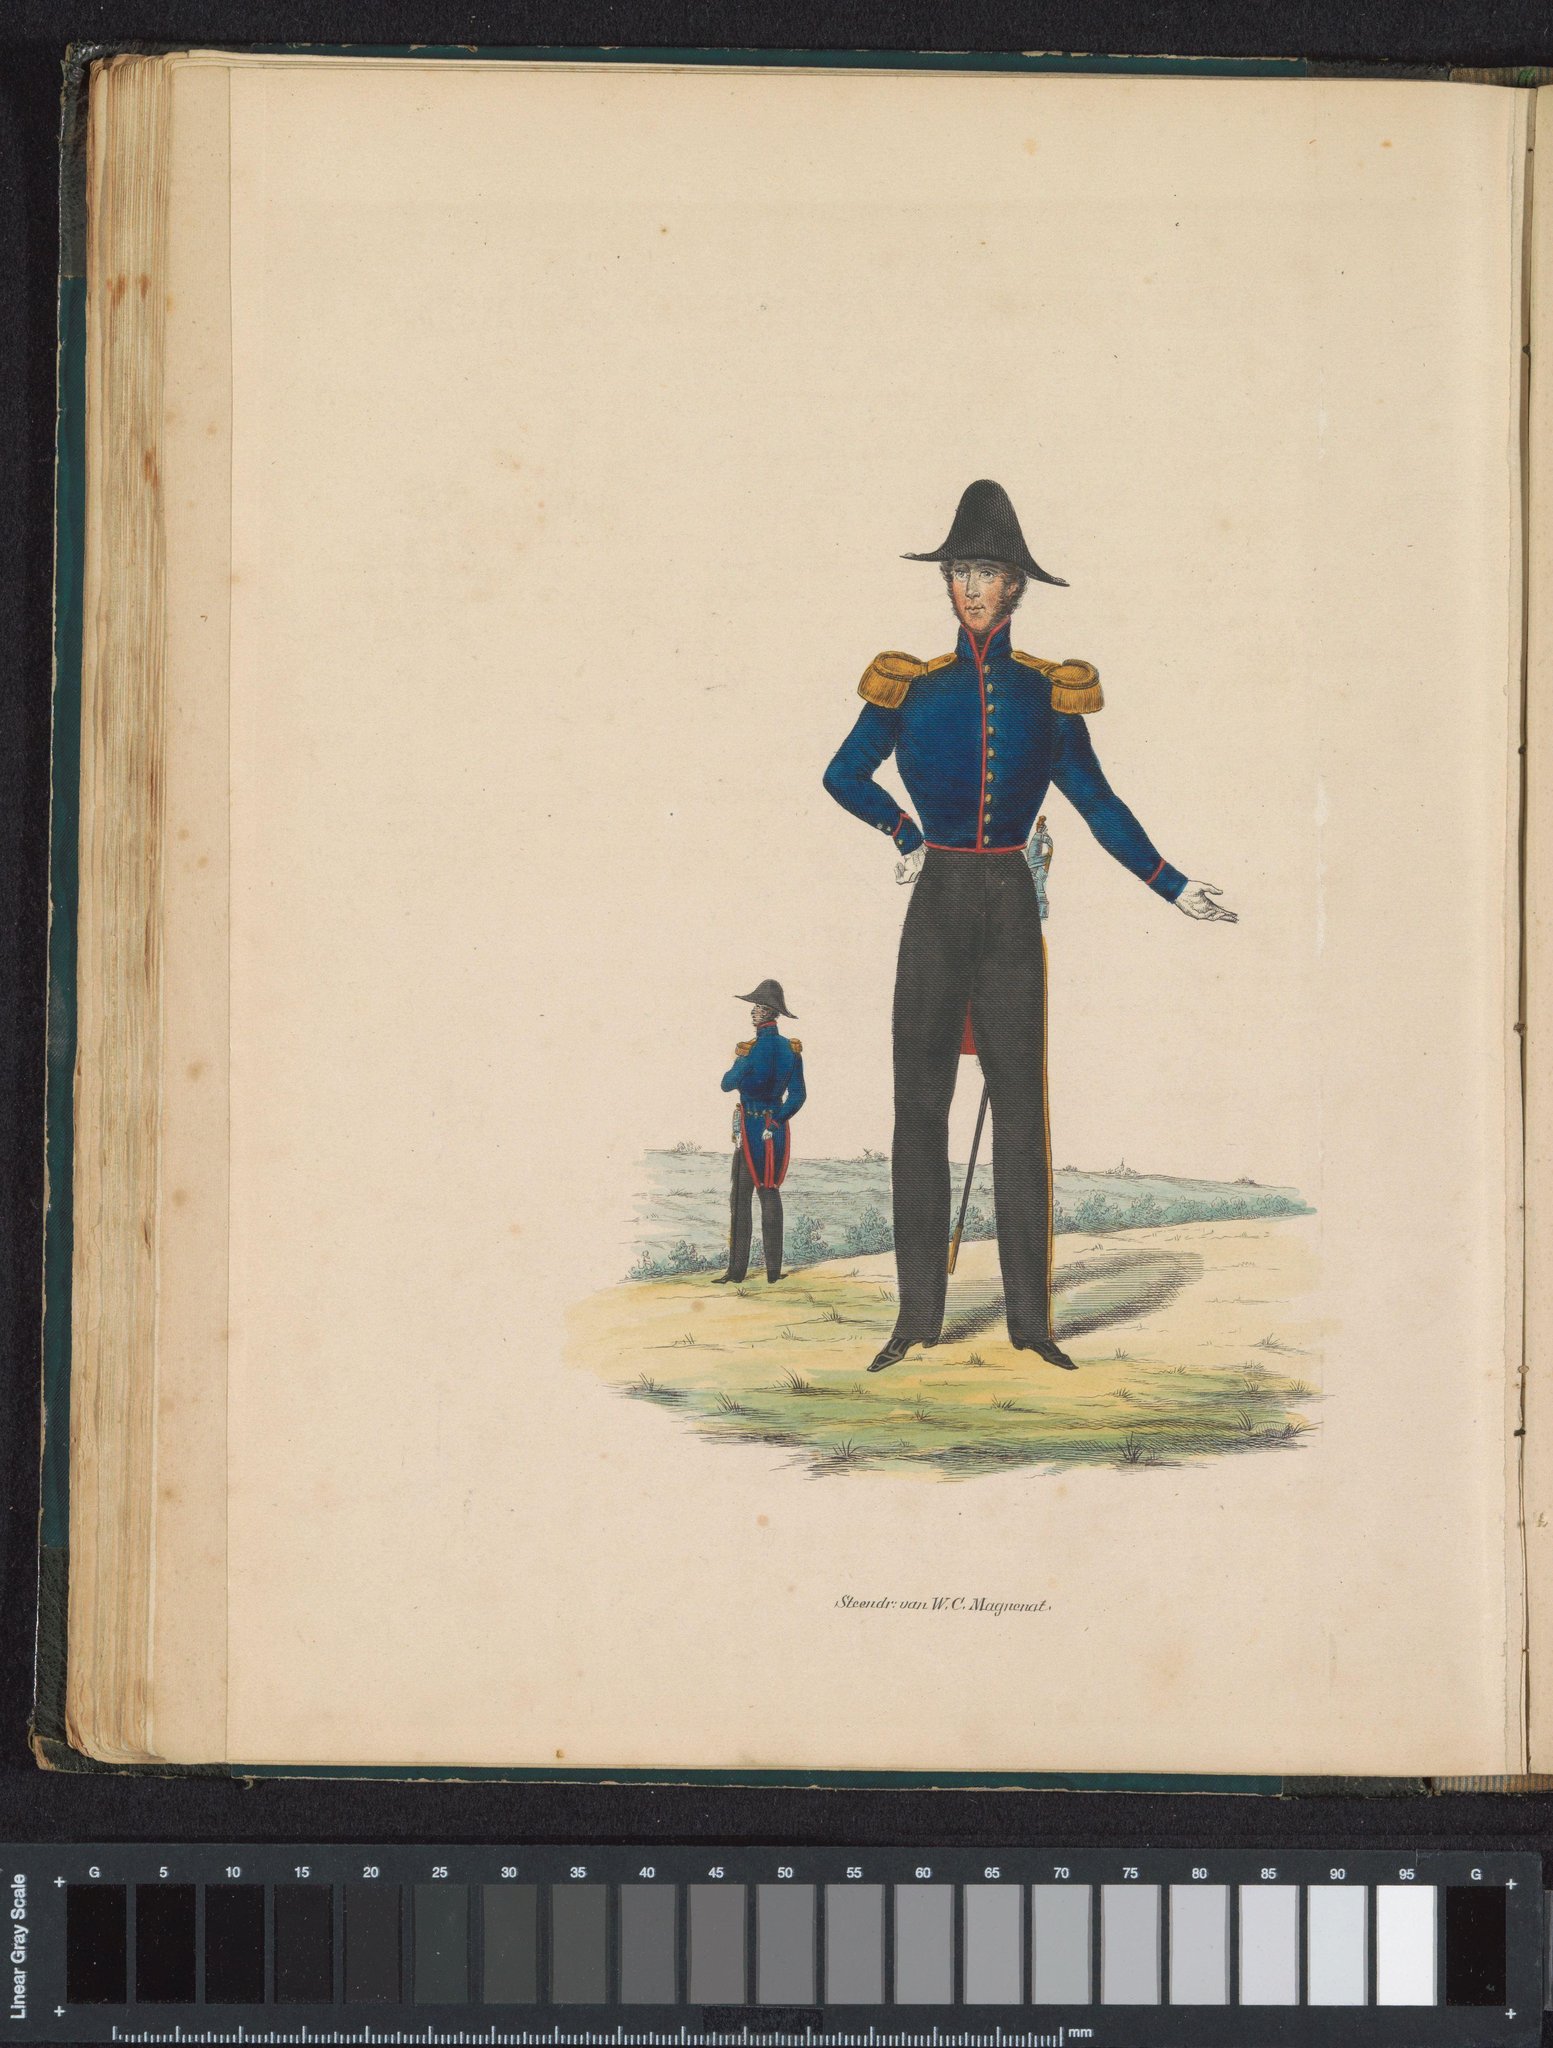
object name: book illustration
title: Officieren van Gezondheid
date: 1845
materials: paper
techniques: hand coloring, lithograph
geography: netherlands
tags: (military) uniforms, netherlands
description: Uniform van officieren van gezondheid. Illustratie in een boek uit 1845 over de uniformen en kledingstukken van de Nederlandse land-, zeemacht en schutterijen in Nederland en in de overzeese gebiedsdelen.